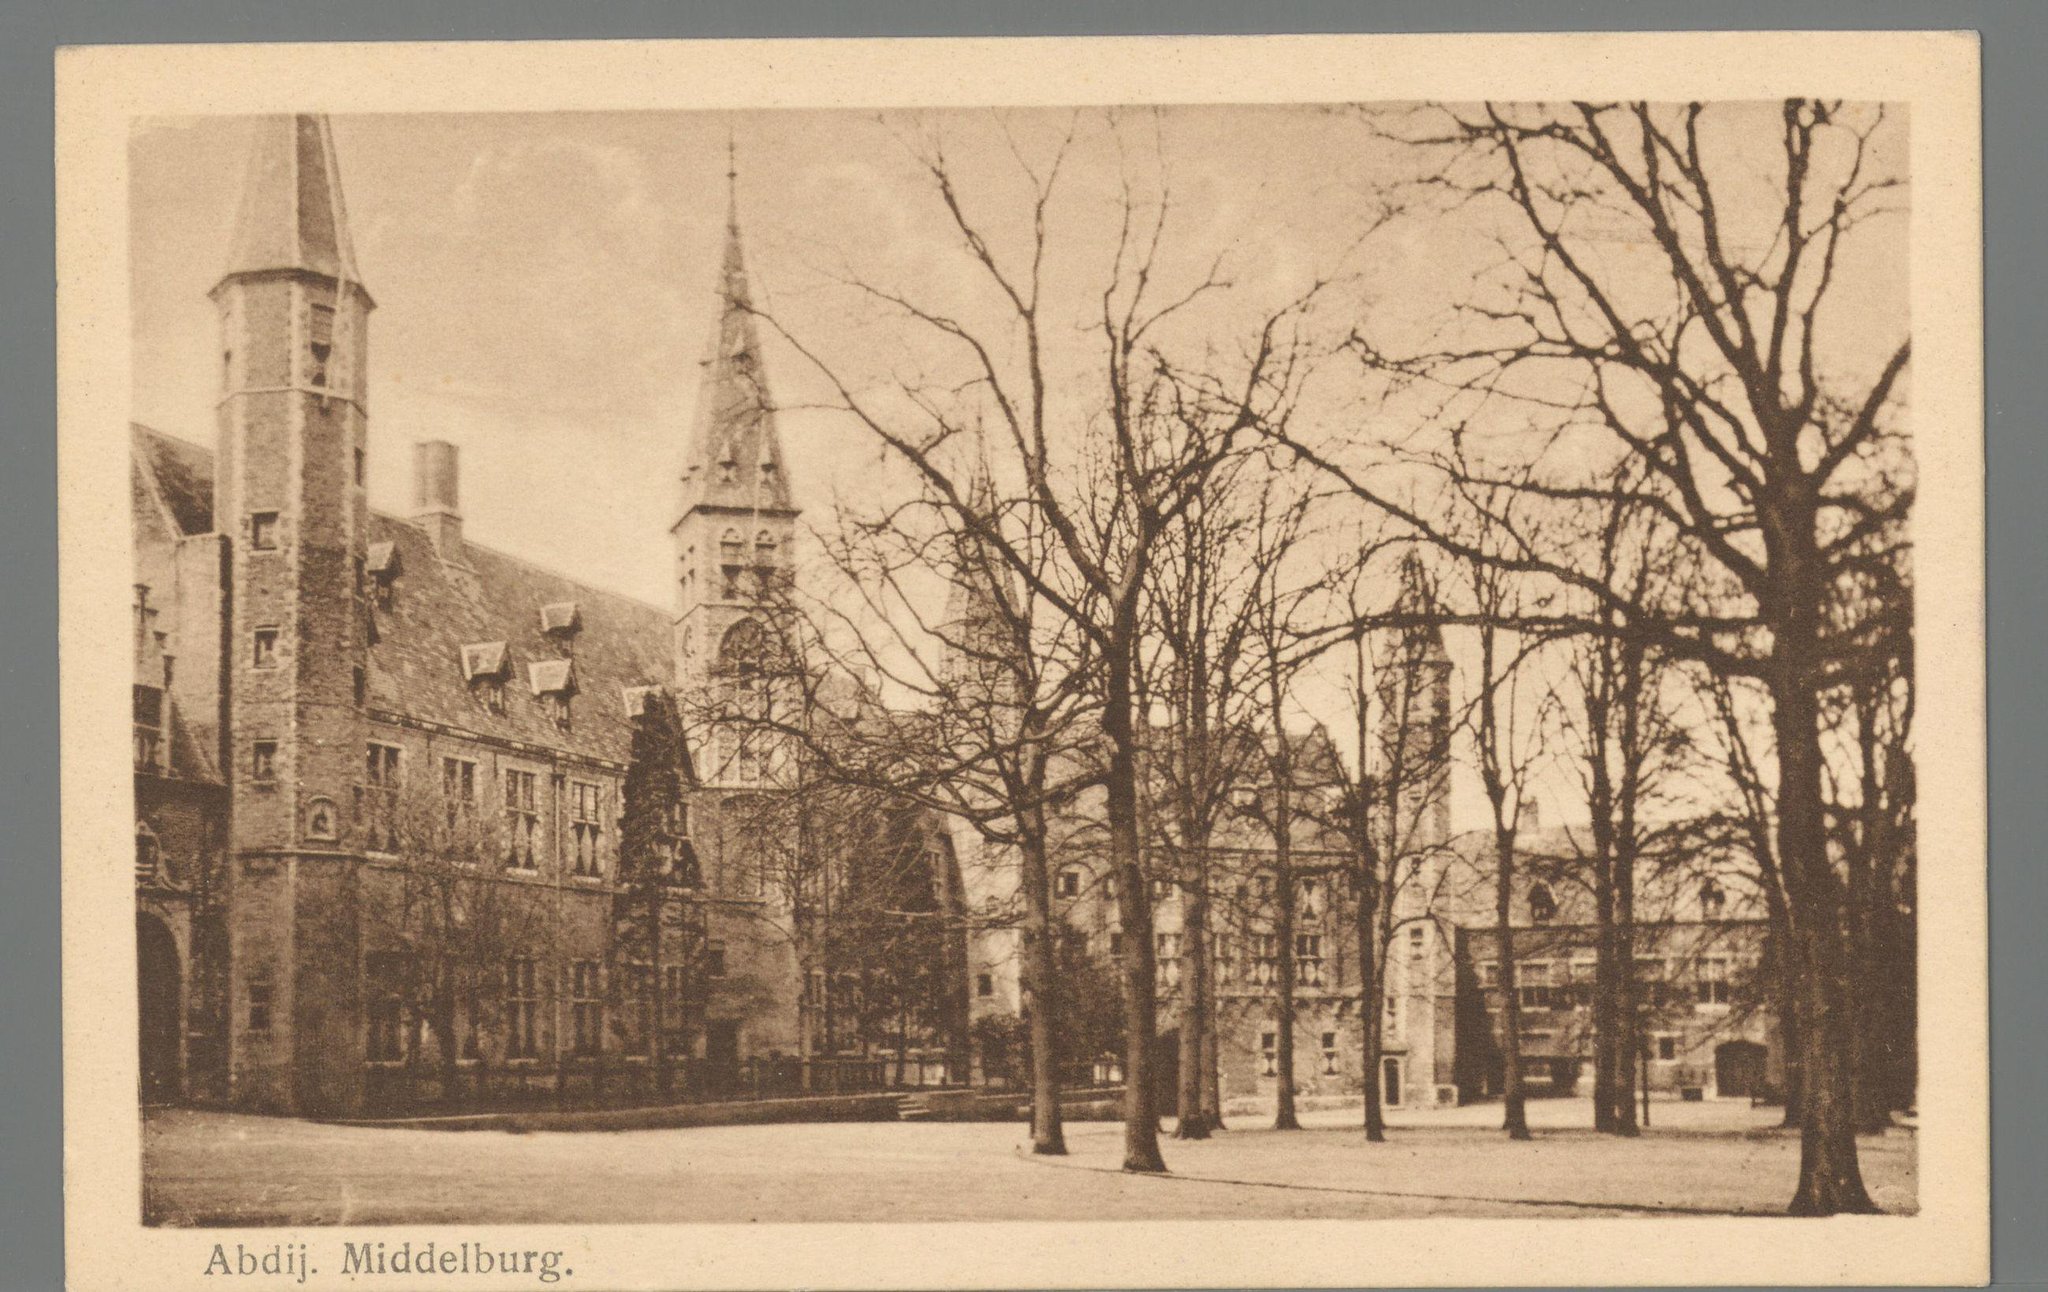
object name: ansichtkaart, prentbriefkaart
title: Abdij. Middelburg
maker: Anonymous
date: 1913-1930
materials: cardboard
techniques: photograph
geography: middelburg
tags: abbey, monastery, convent ~ roman catholic church